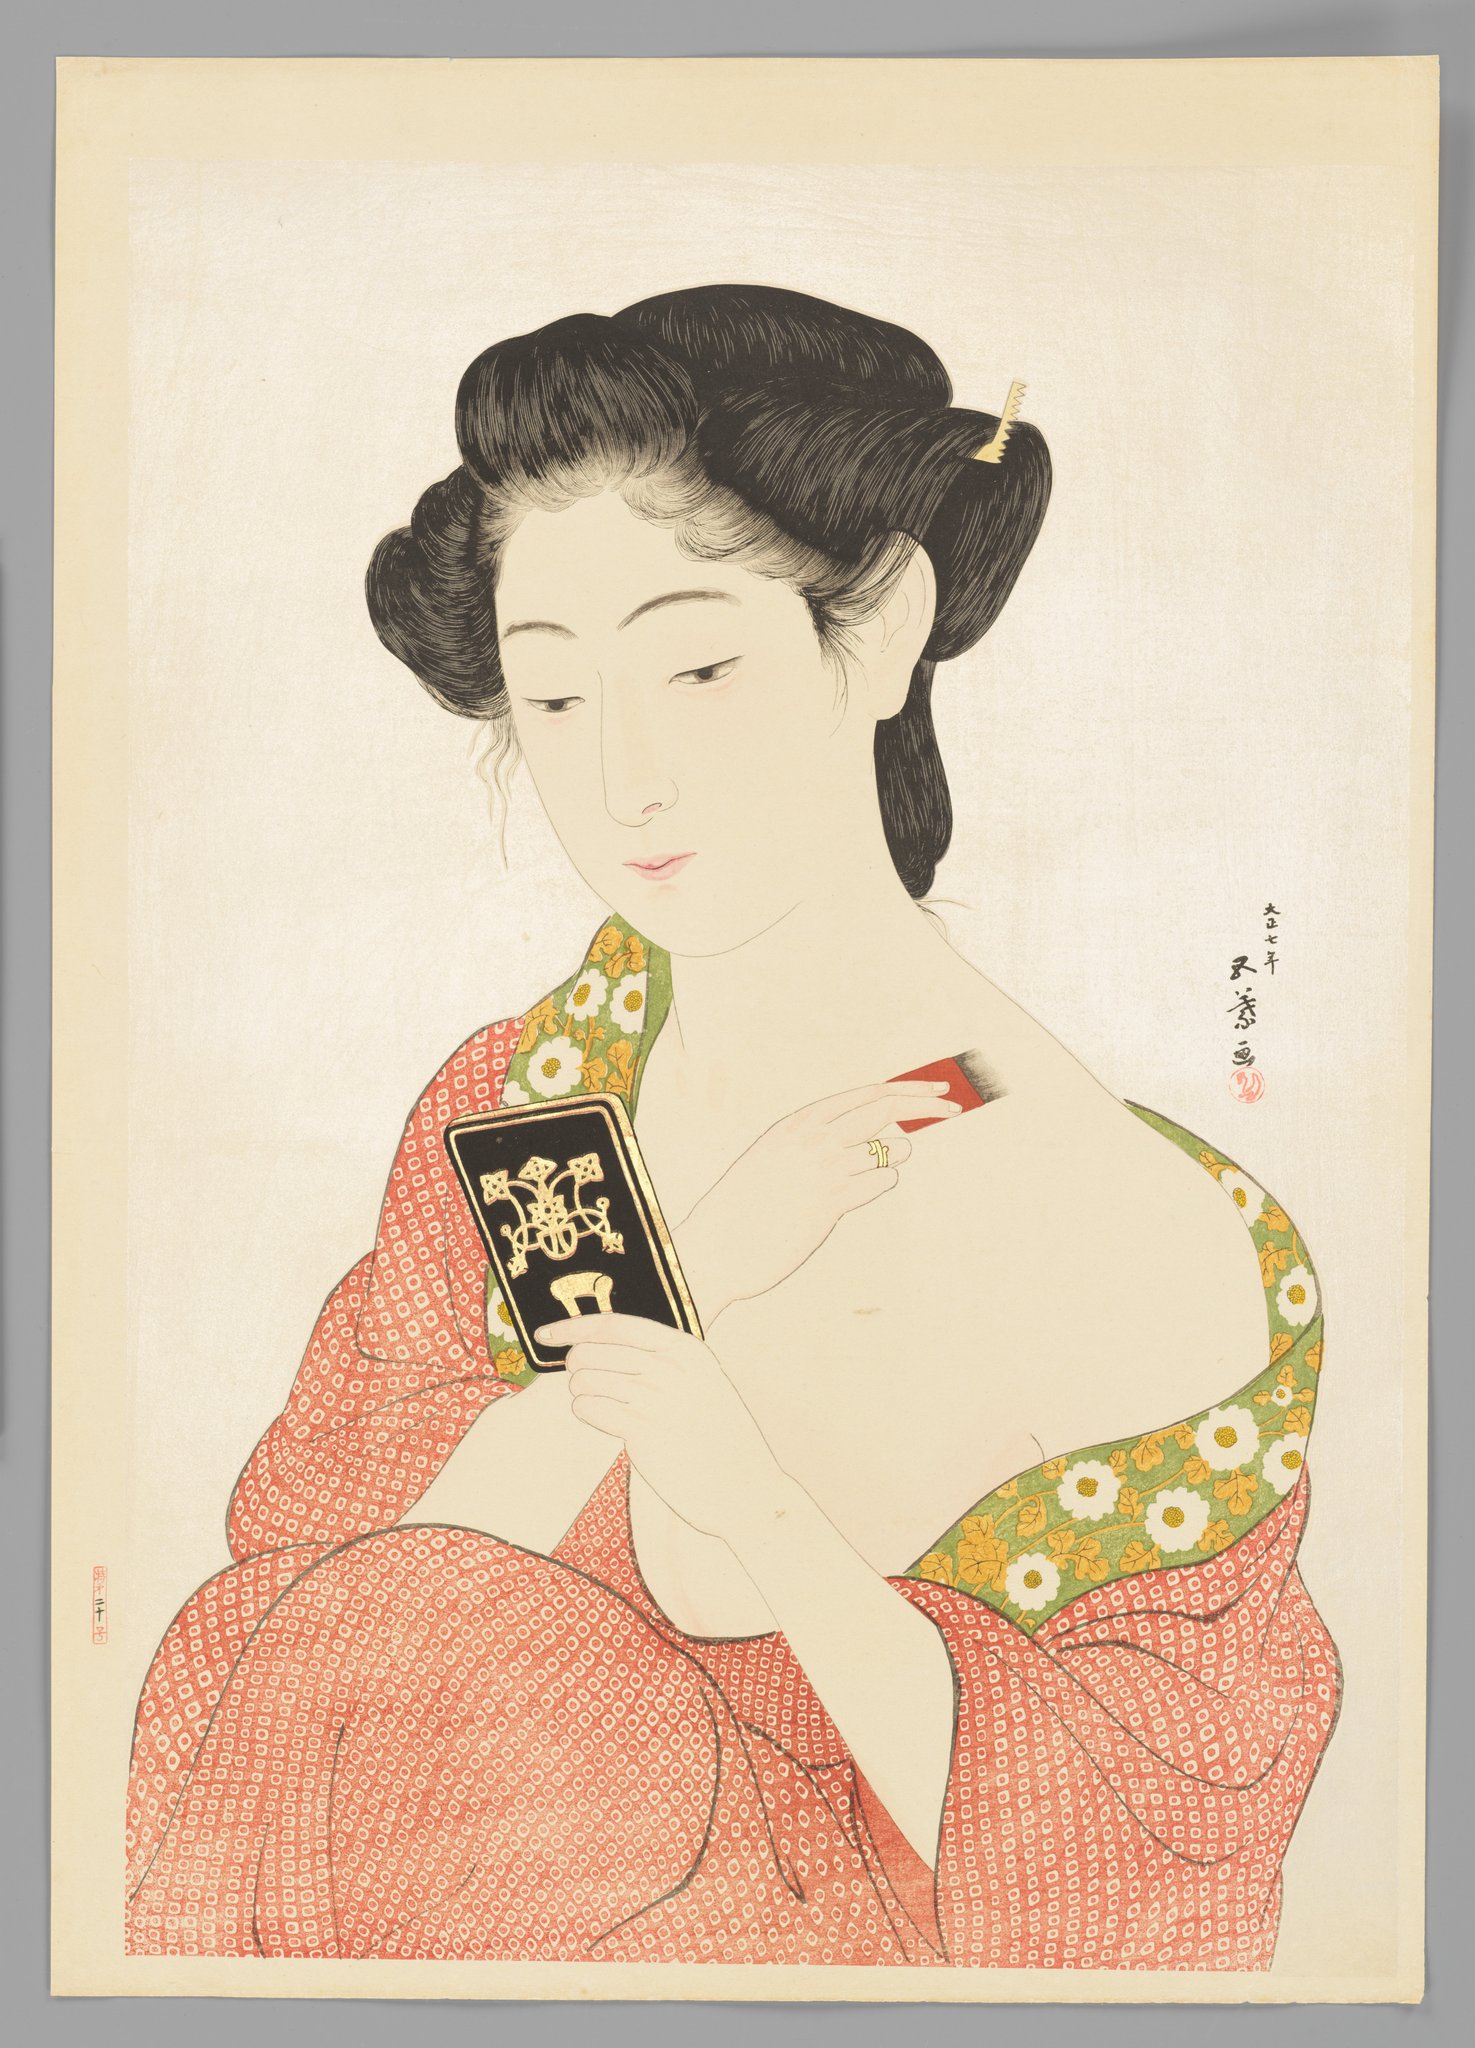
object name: woodblock print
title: Woman Applying Makeup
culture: japanese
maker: hashiguchi goyō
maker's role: artist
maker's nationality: japanese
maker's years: 1881-1921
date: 1918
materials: gold, ink, mica, paper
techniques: woodblock print